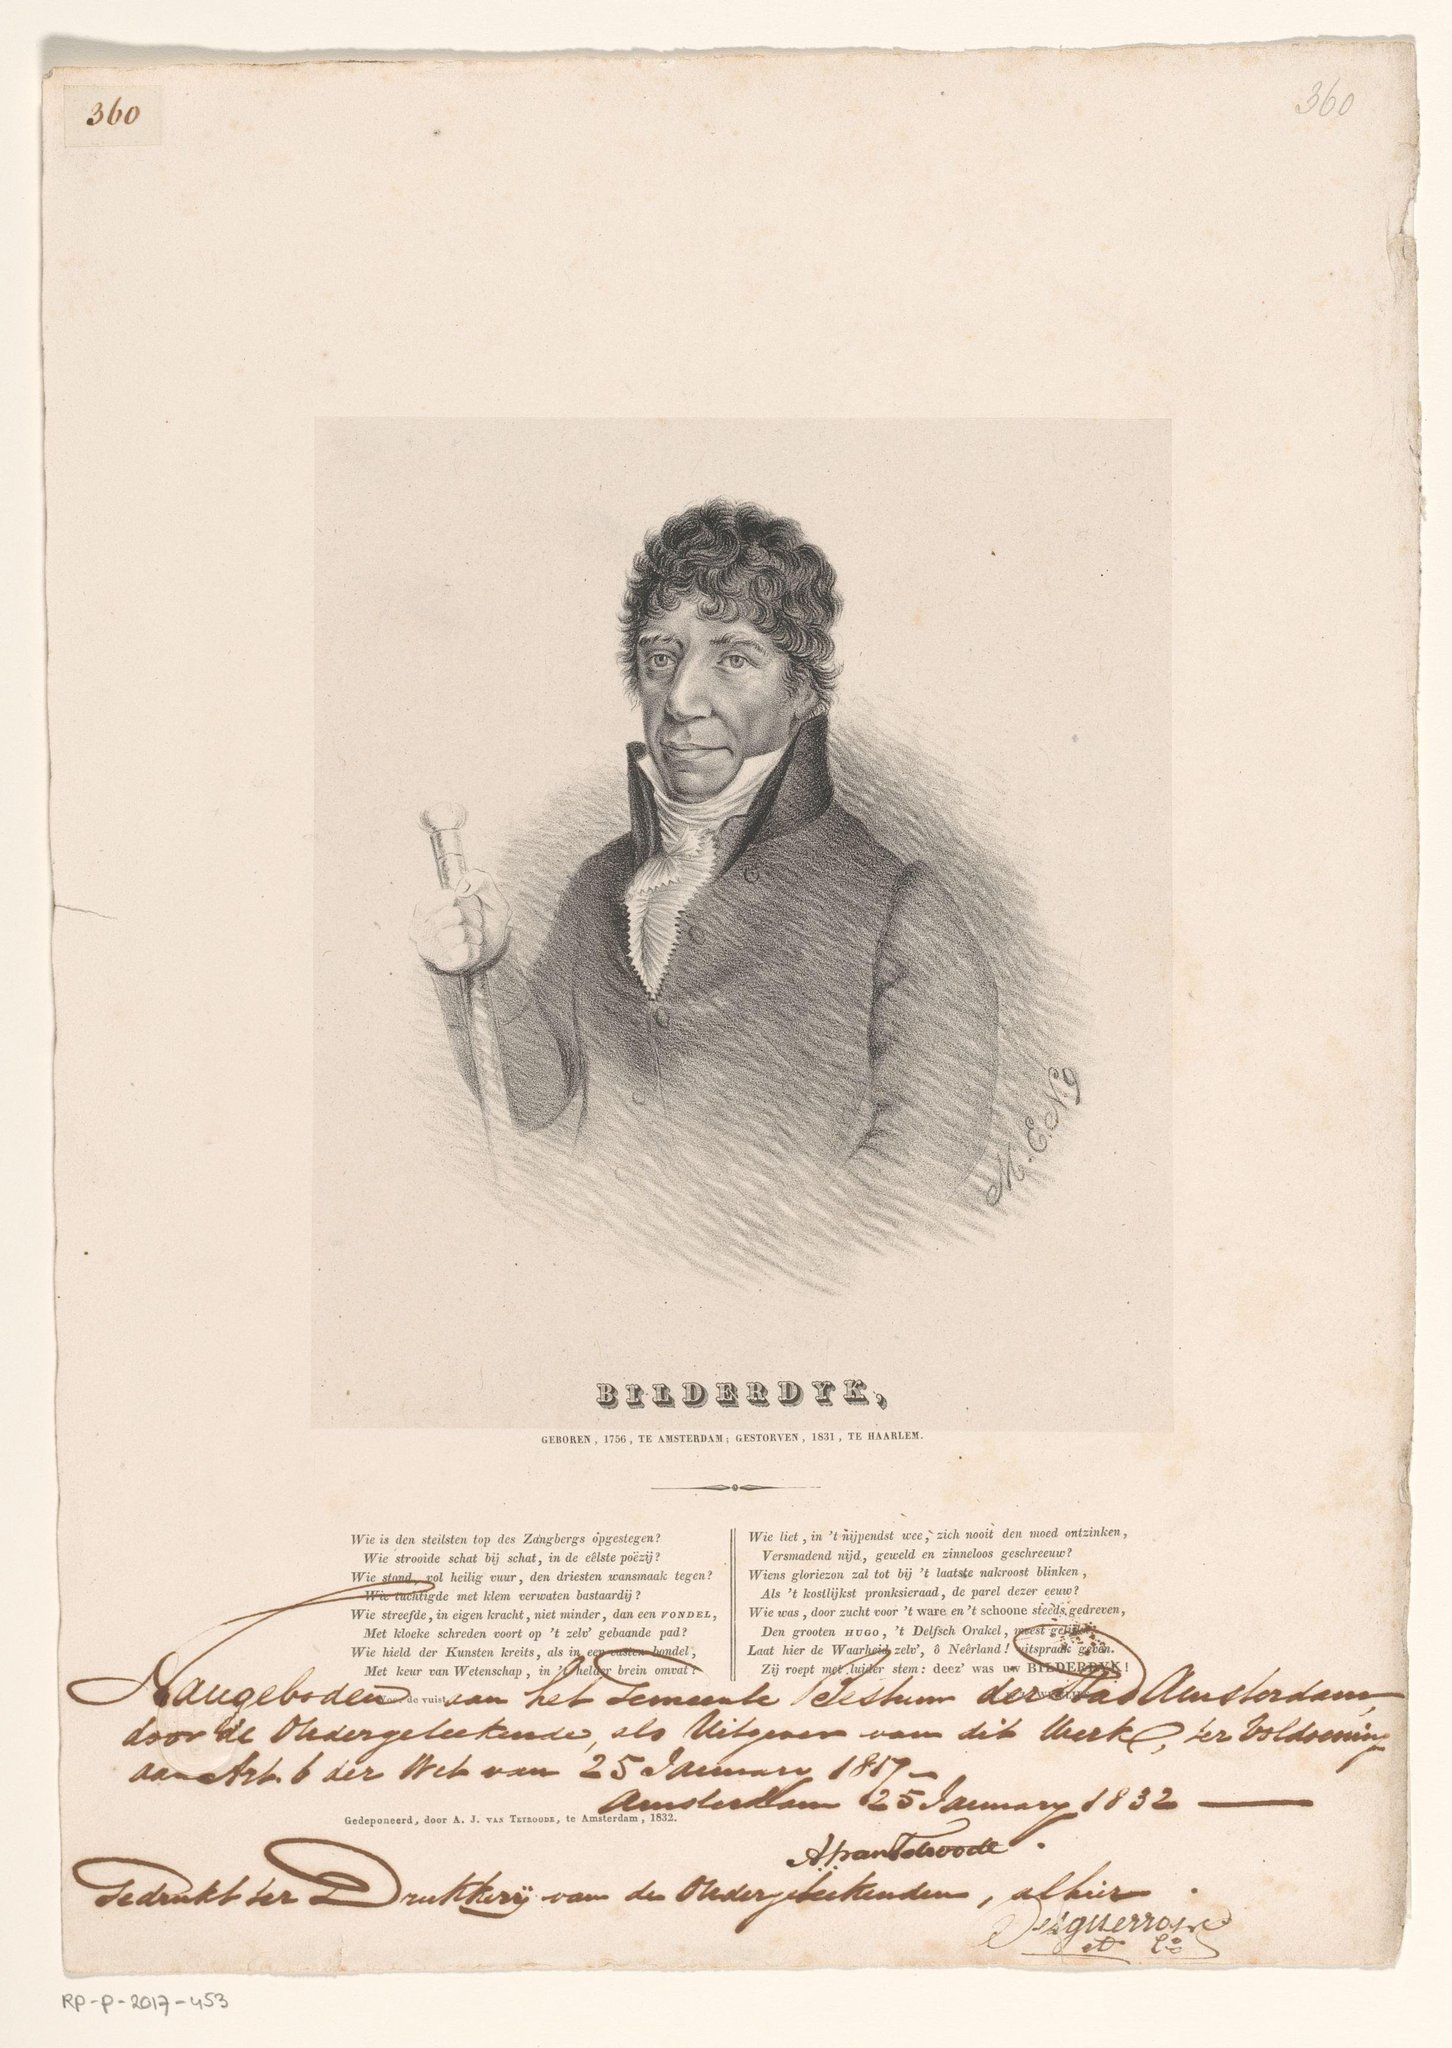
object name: print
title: Portret van Willem Bilderdijk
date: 1832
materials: paper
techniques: lithograph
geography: amsterdam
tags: amsterdam, haarlem, draughtsman, willem bilderdijk, historical persons (+ half-length portrait)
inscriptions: : ‘Aangeboden van het Gemeente Bestuur der stad Amsterdam / door de ondergeteekenden, als uitgever van dit werk, ter voldoening / aan Art. 6 der wet van 25 January 1817 - / Amsterdam 25 January 1832’, : ‘Gedrukt ter Drukkerij van de ondergeteekenden, alhier. / Desguerrois & Co’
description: Onder het portret een gedicht door S. J. Wiselius.